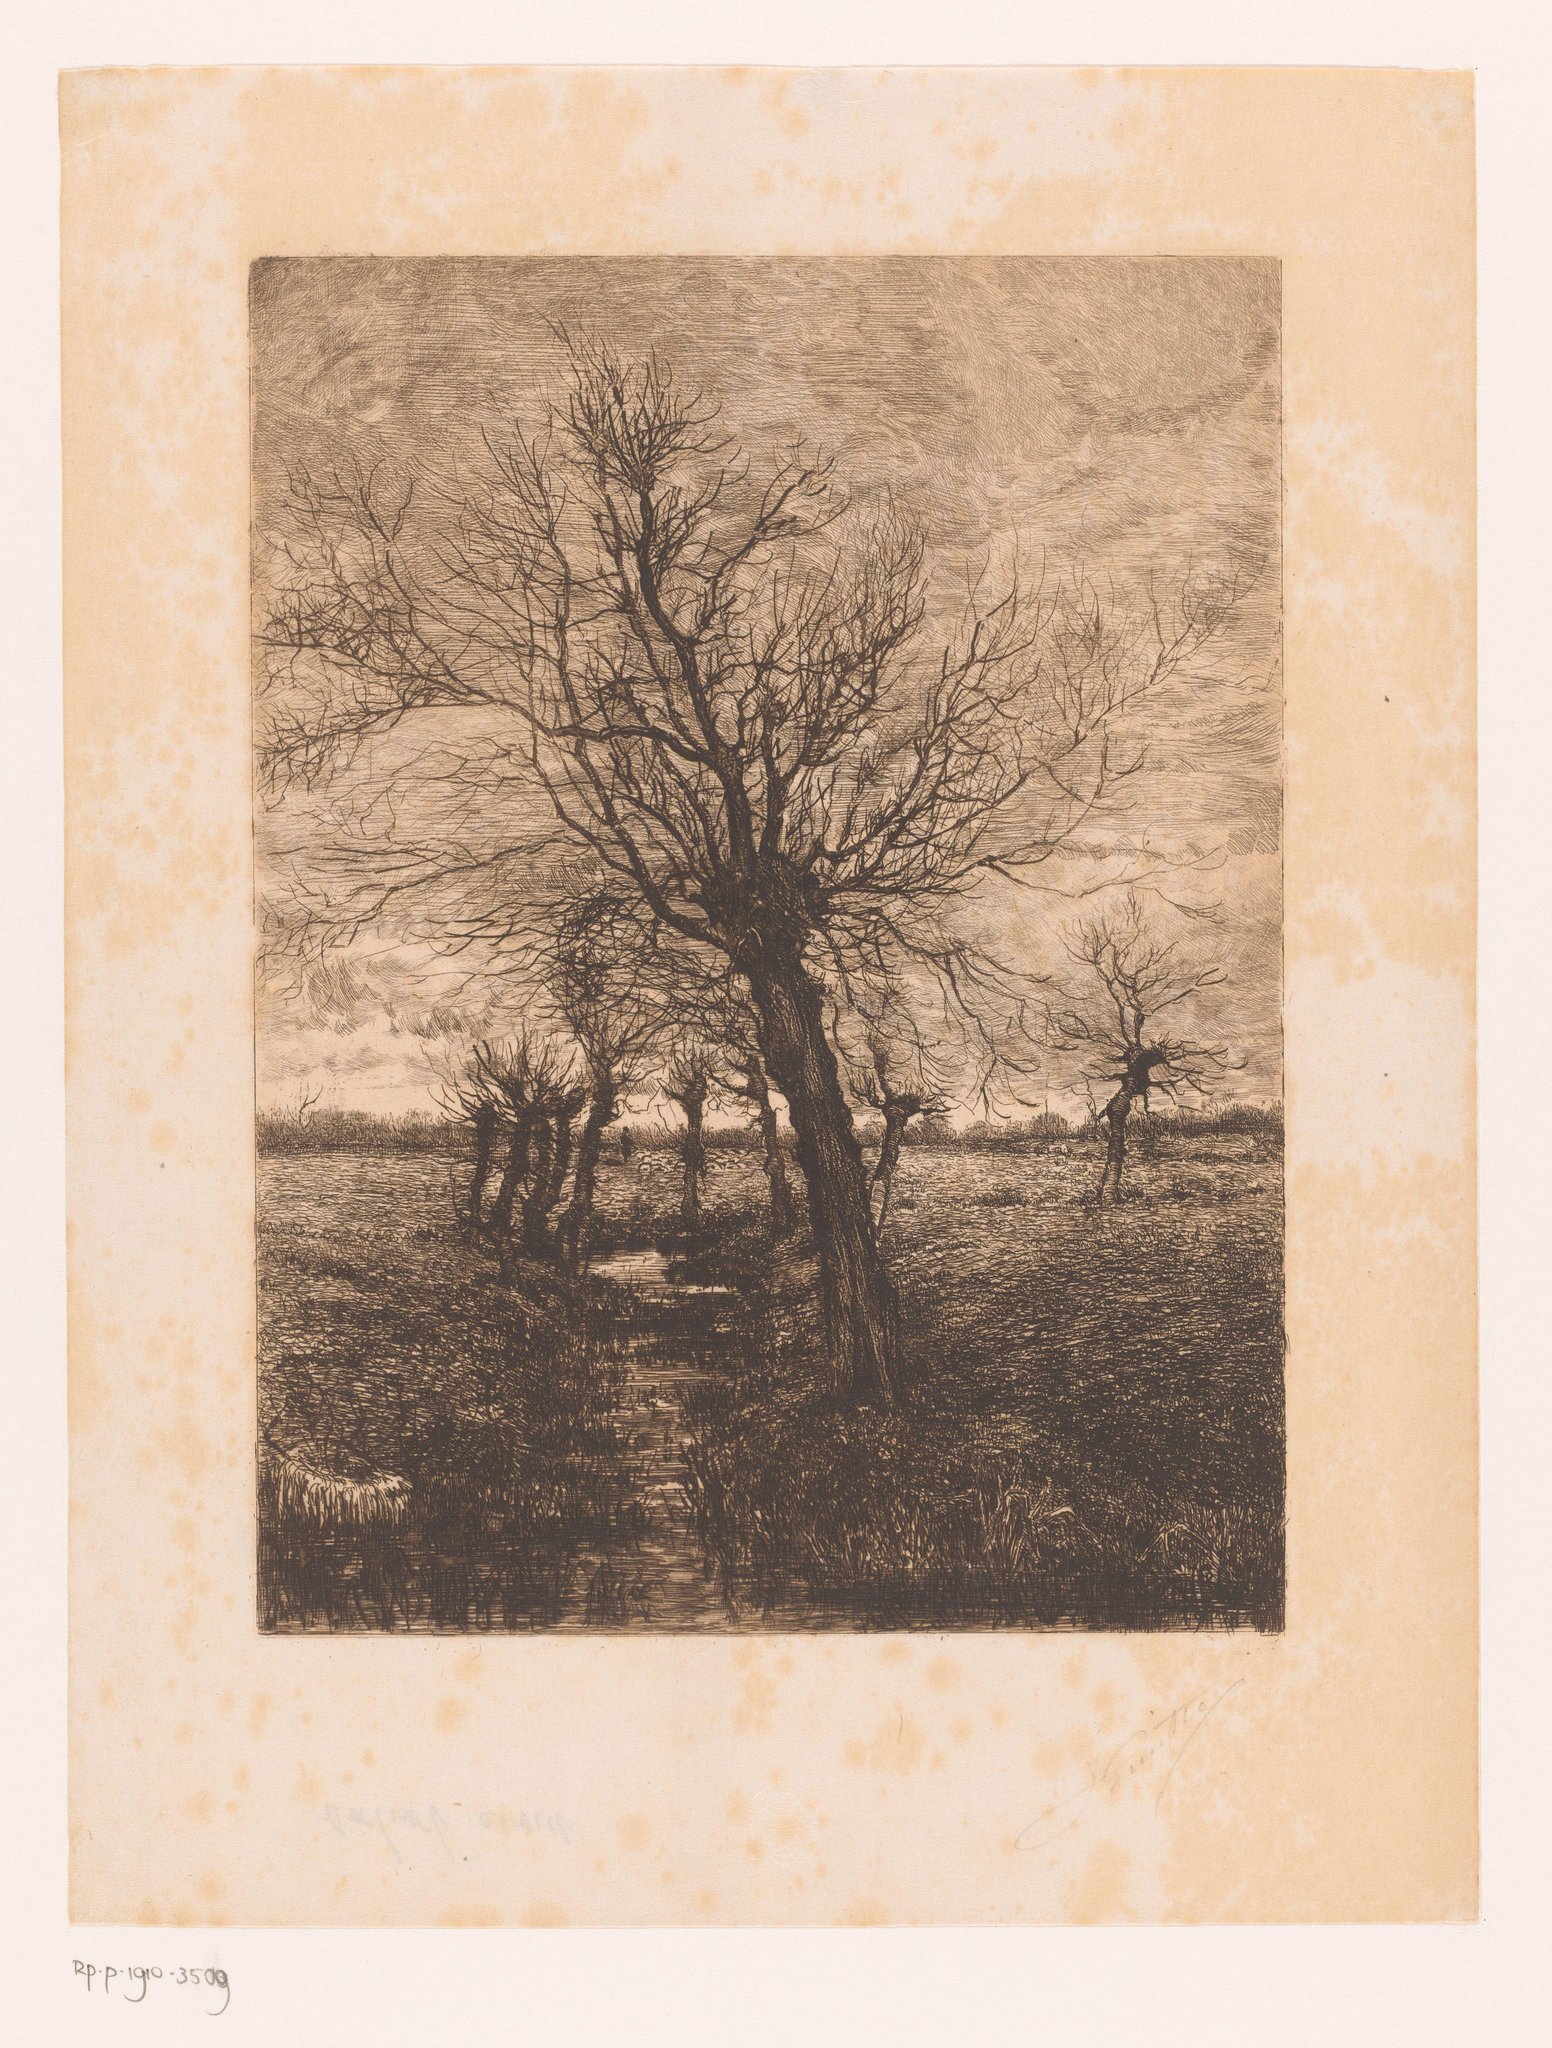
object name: print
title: Landschap met wilgen aan een beek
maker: jules guiette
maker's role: print maker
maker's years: 1852-1901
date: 1862-1901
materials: paper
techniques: drypoint, etching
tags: landscapes in the temperate zone, trees: willow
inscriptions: collector's mark: Lugt 2228, workshop stamp: ‘Antwerpsche Etsers 1880’